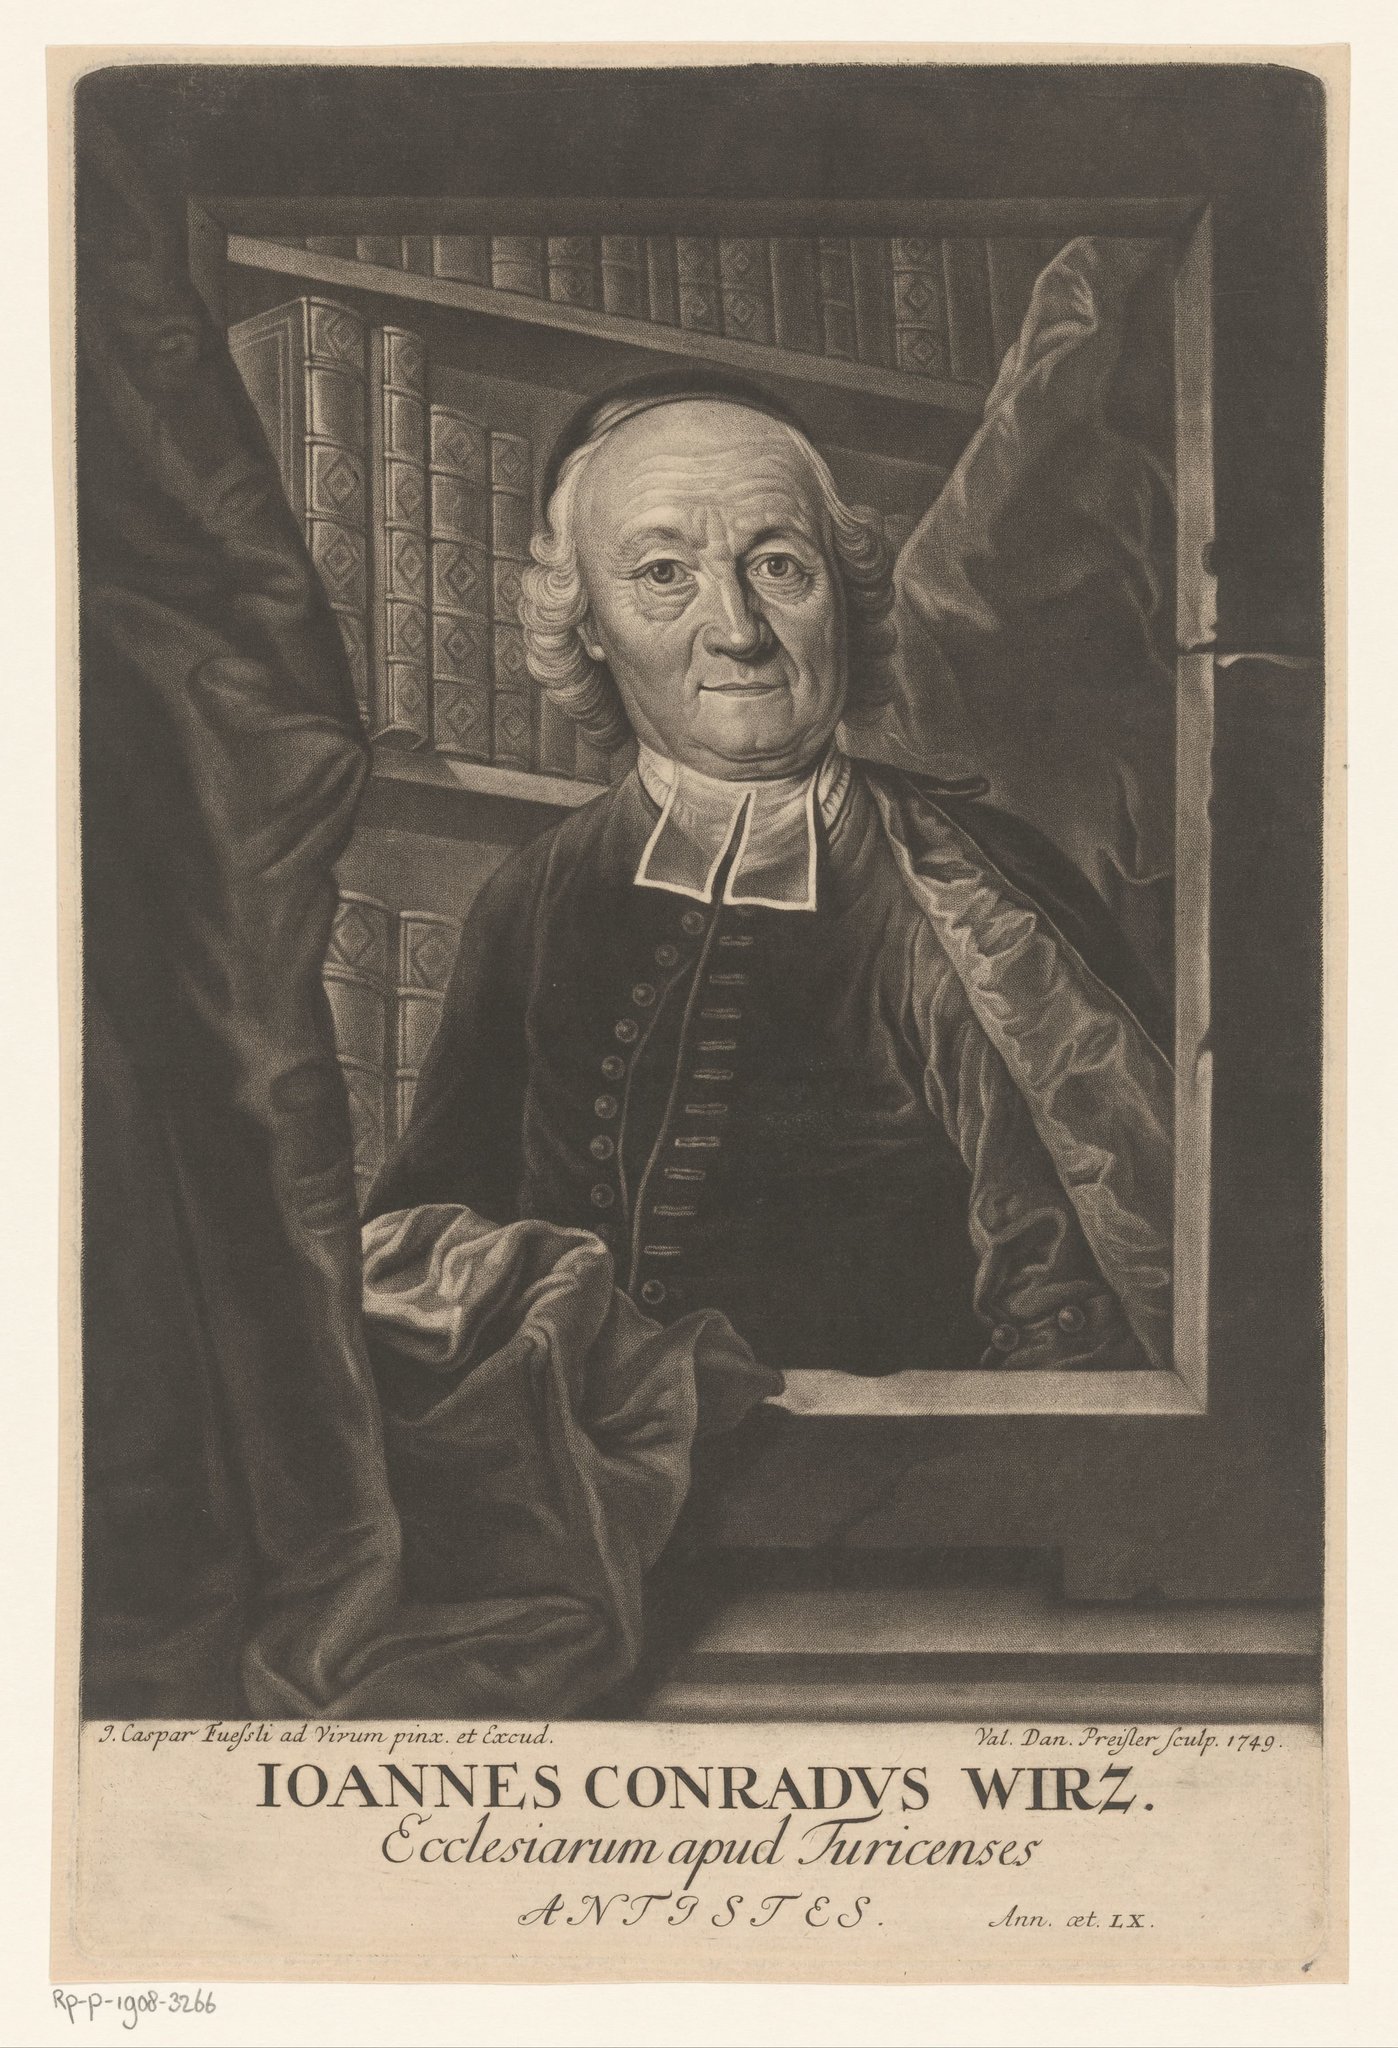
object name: print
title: Portret van Johann Konrad Wirz op 60-jarige leeftijd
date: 1749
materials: paper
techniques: mezzotint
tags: bookshelves, historical persons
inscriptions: collector's mark: Lugt 2228